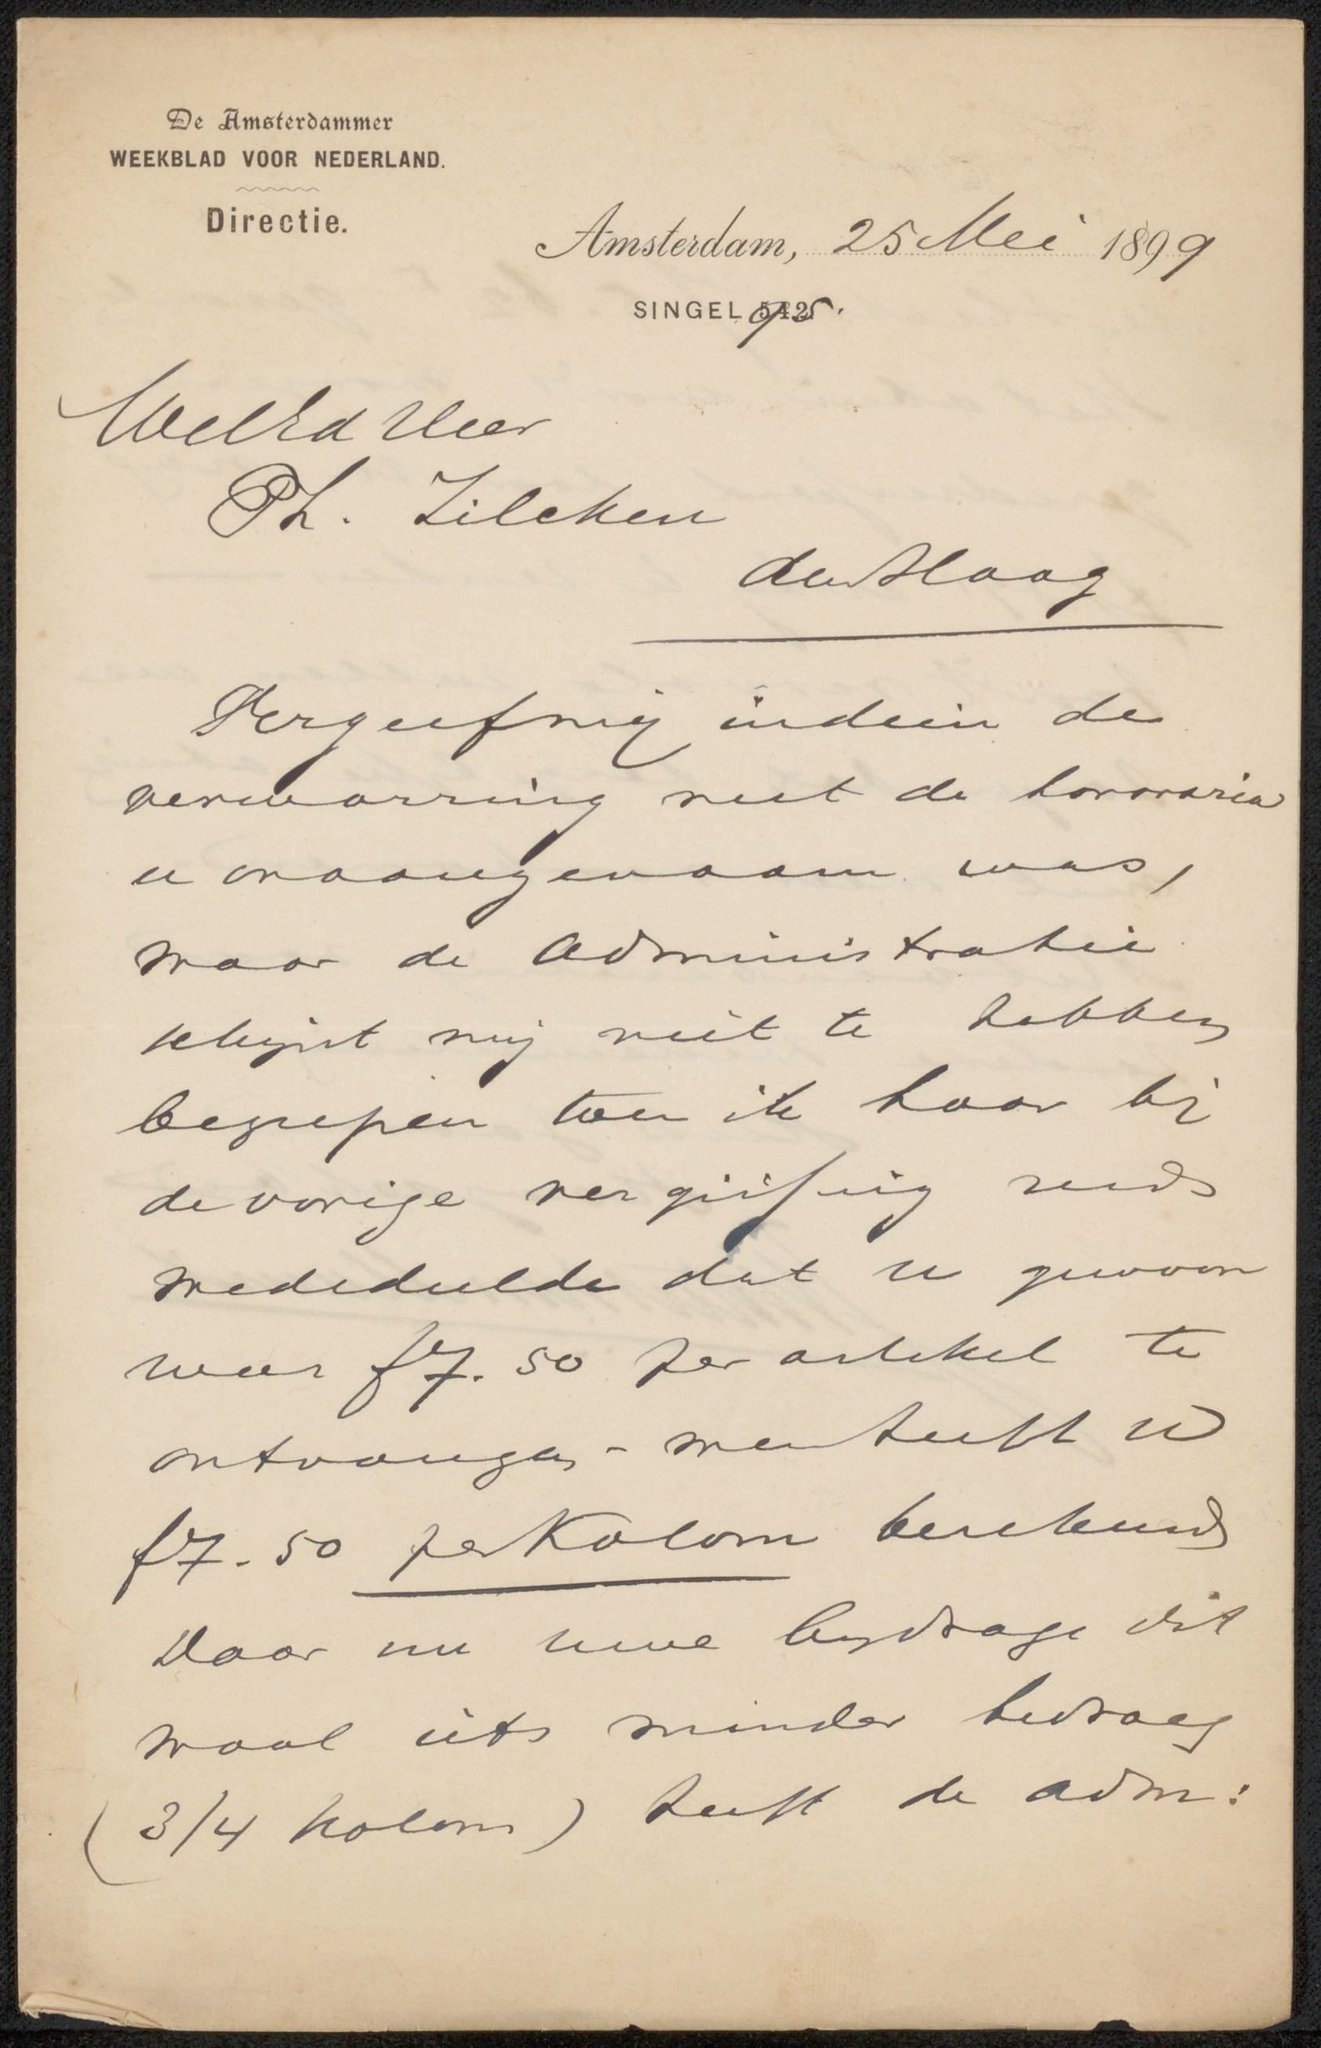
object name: letter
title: Brief aan Philip Zilcken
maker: justus van maurik jr.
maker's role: schrijver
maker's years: 1846-1904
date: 1899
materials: ink, paper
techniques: pen, printing, writing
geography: amsterdam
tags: the hague, painter, draughtsman, philip zilcken, money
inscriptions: collector's mark: ‘RPK’